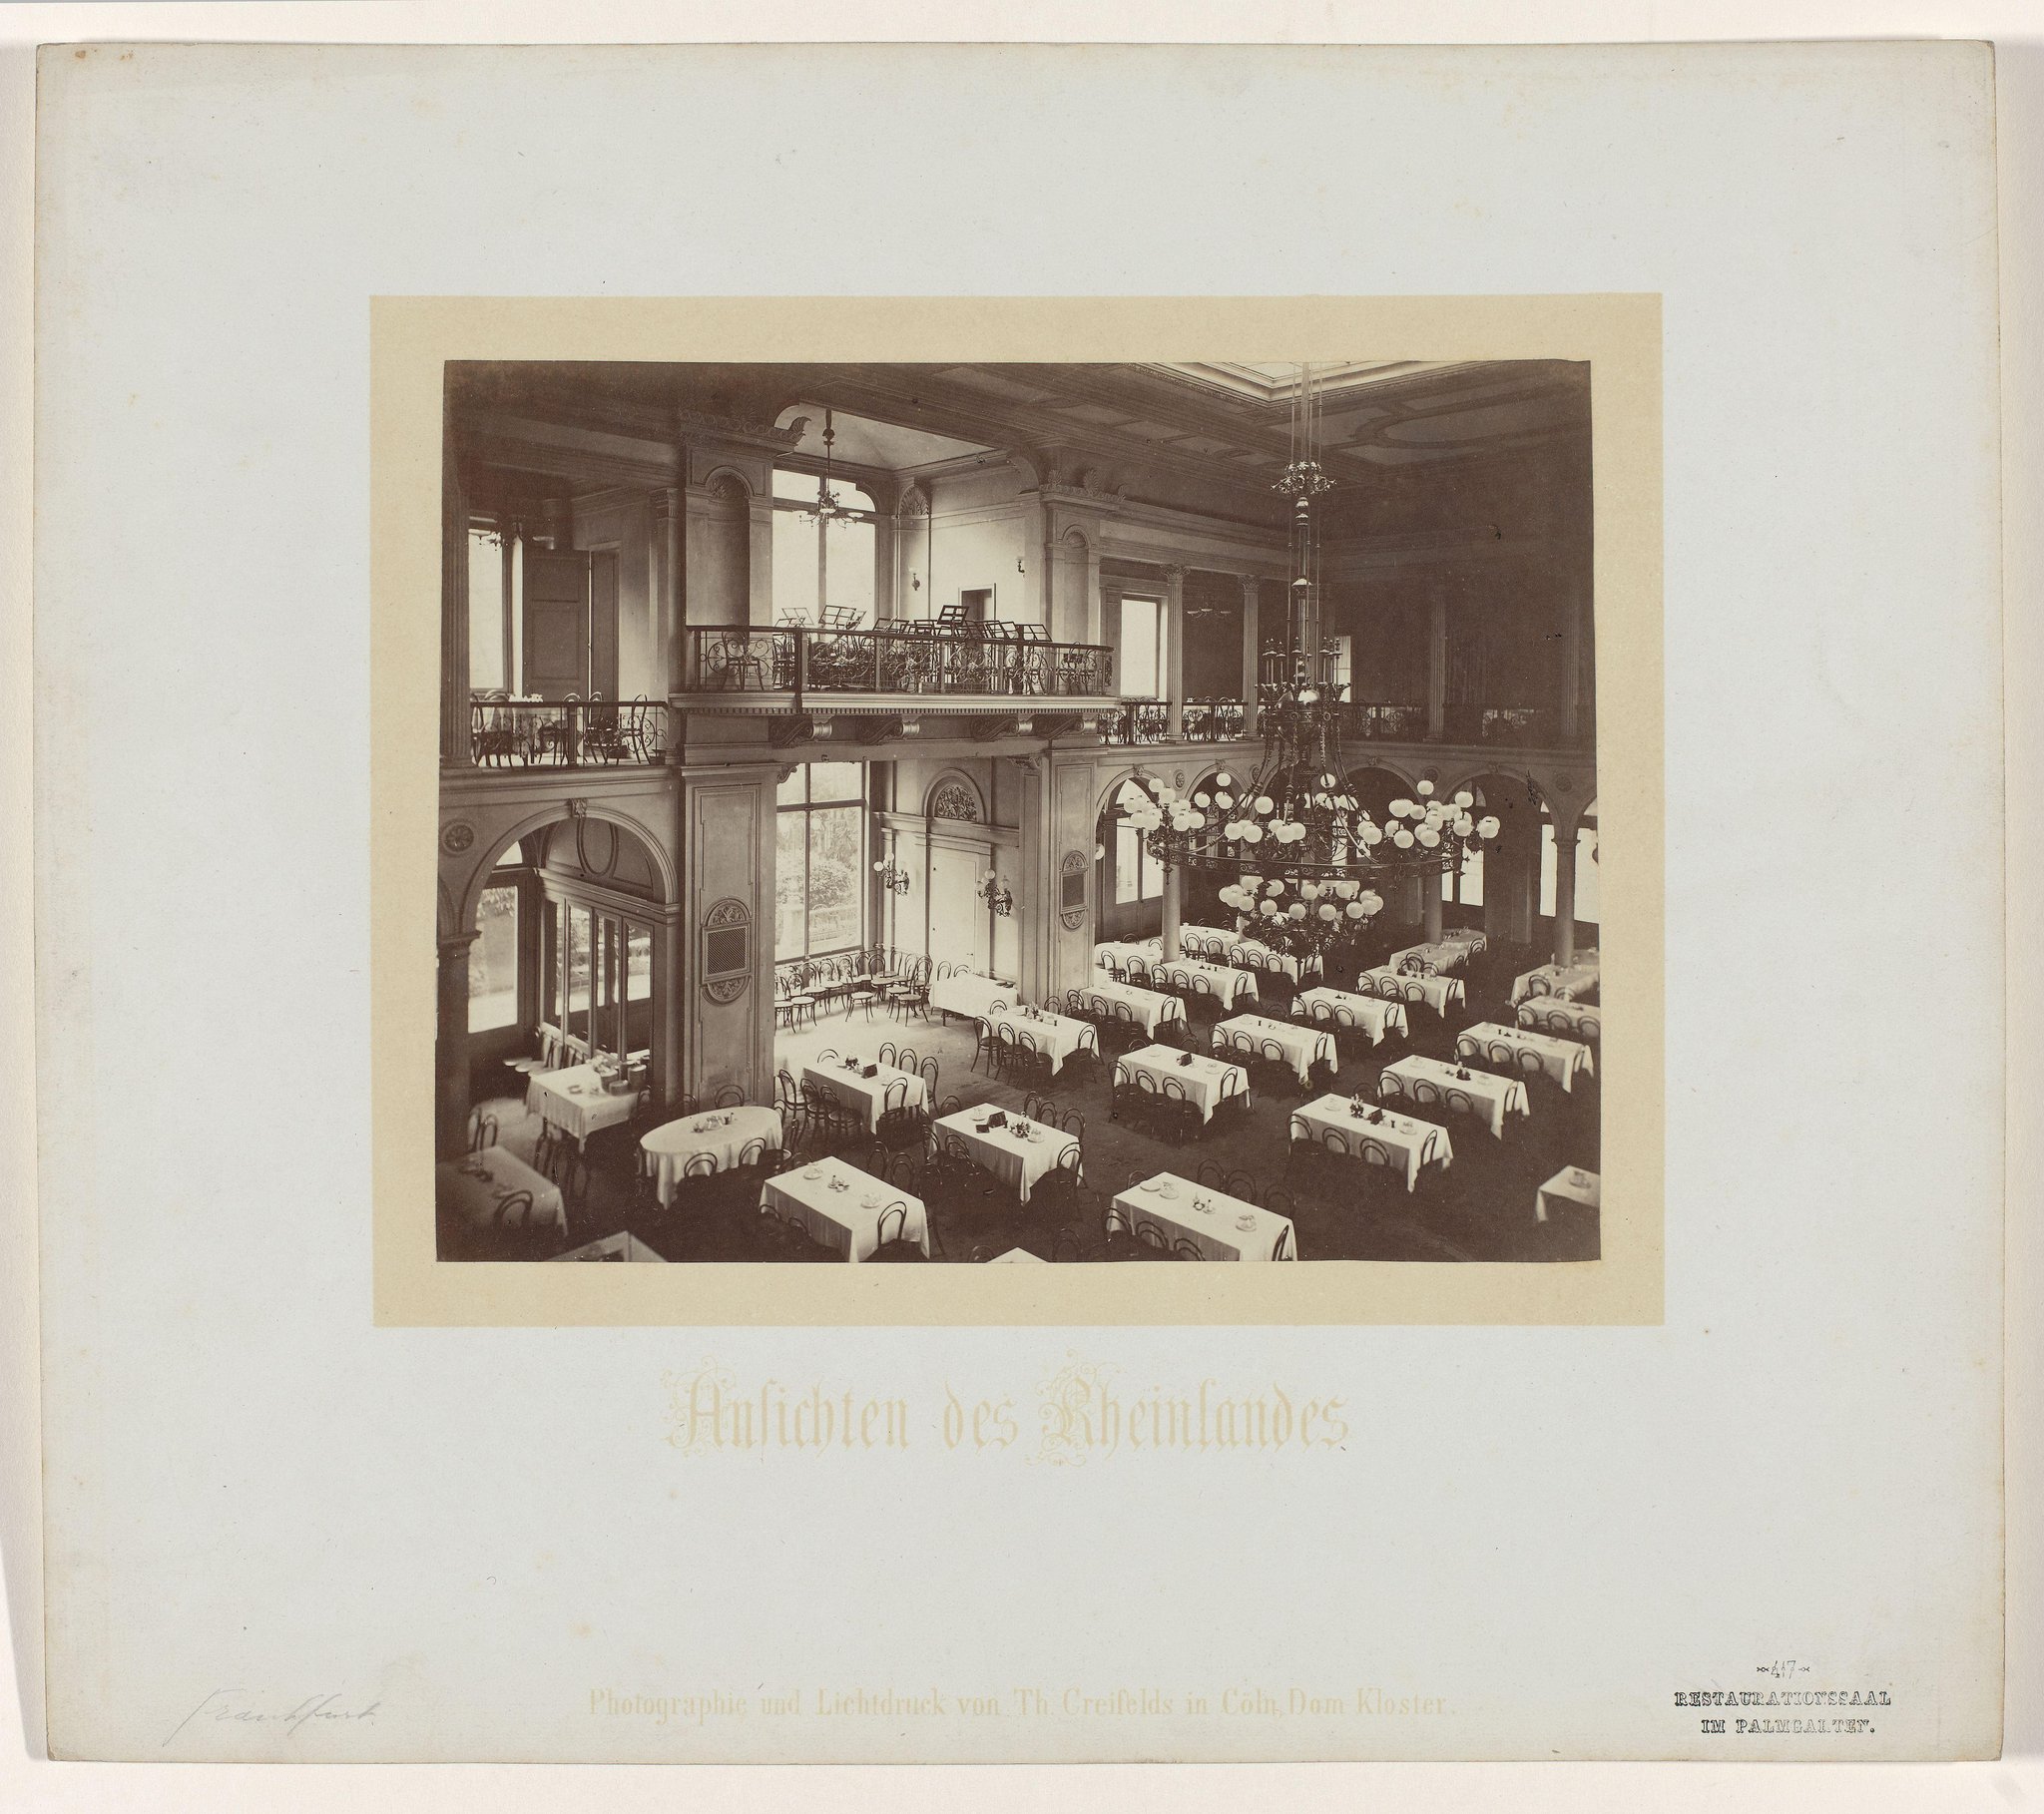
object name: photograph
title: Ansichten des Rheinlandes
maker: theodor creifelds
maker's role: publisher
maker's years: 1815-1875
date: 1860-1875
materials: cardboard, photographic support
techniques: albumen print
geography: frankfurt am main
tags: botanic garden, 'hortus botanicus'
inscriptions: title: ‘..’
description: Interieur van de grote eetzaal in Palmengarten, Frankfurt am Main.